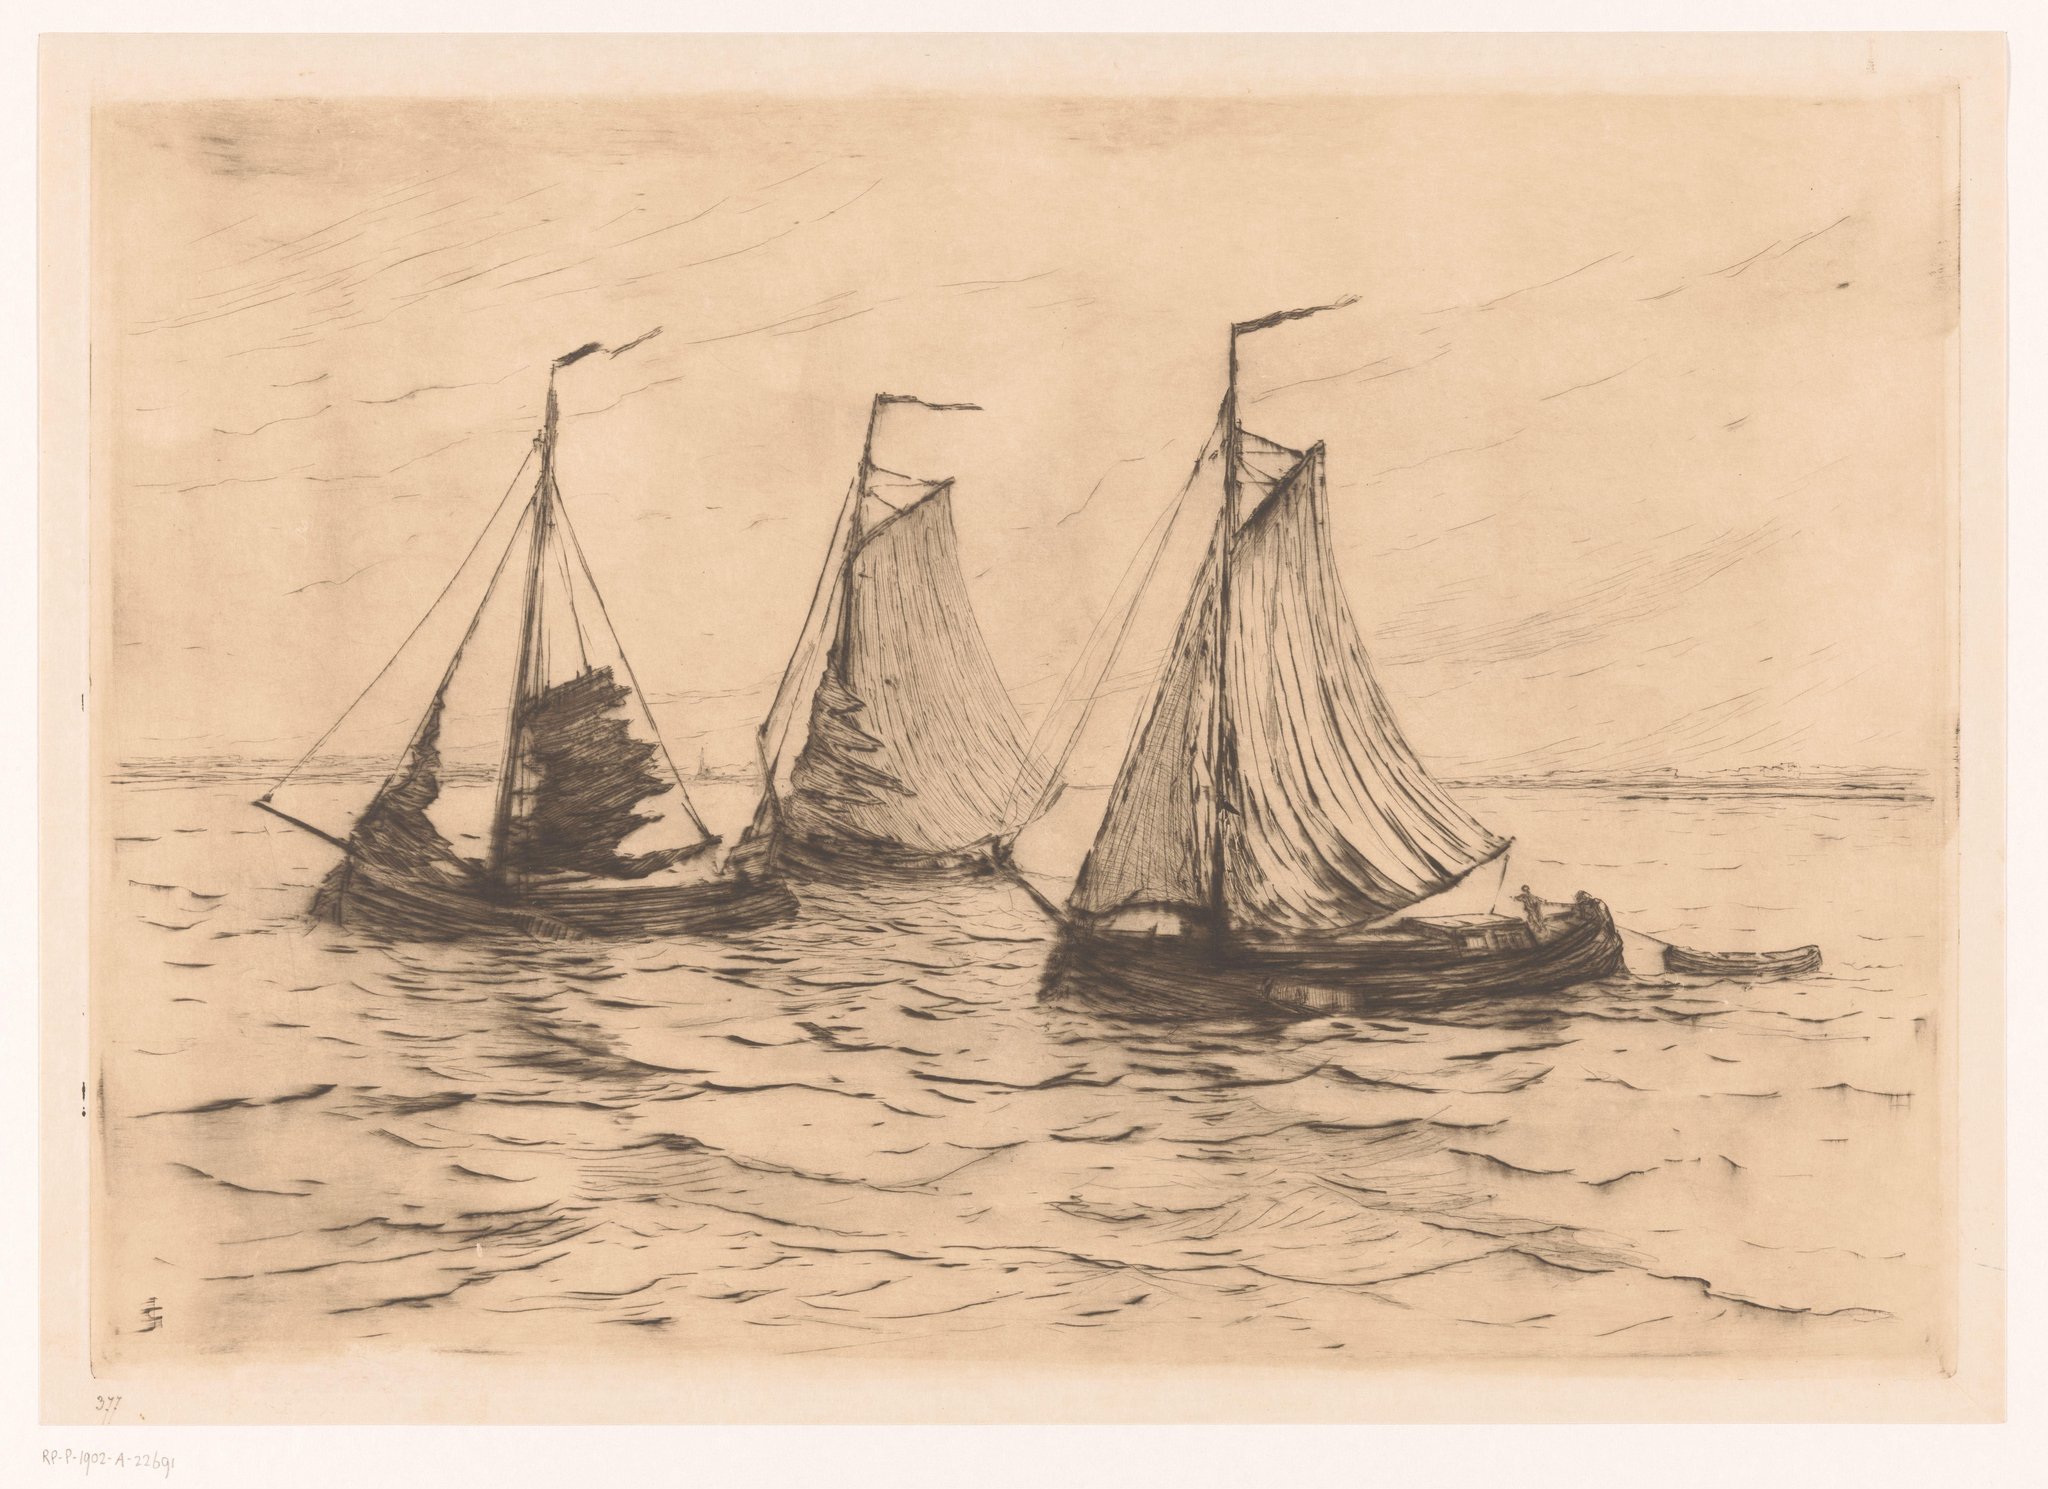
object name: print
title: Bateaux sur la Meuse devant Dordrecht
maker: carel nicolaas storm van s-gravesande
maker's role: draughtsman, print maker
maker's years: 1841-1924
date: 1889-1902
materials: paper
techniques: drypoint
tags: sailing-ship, sailing-boat, dordrecht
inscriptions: number: ‘377’, collector's mark: Lugt 2228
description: Mogelijk vermeld in: Storm van 's-Gravesande, Charles. Catalogue des eaux-fortes et lithographies. New York: s.n., 1903, of in een onbekende latere uitgave van het manuscript. Vermoedelijk vermeld als catalogusnummer 377.